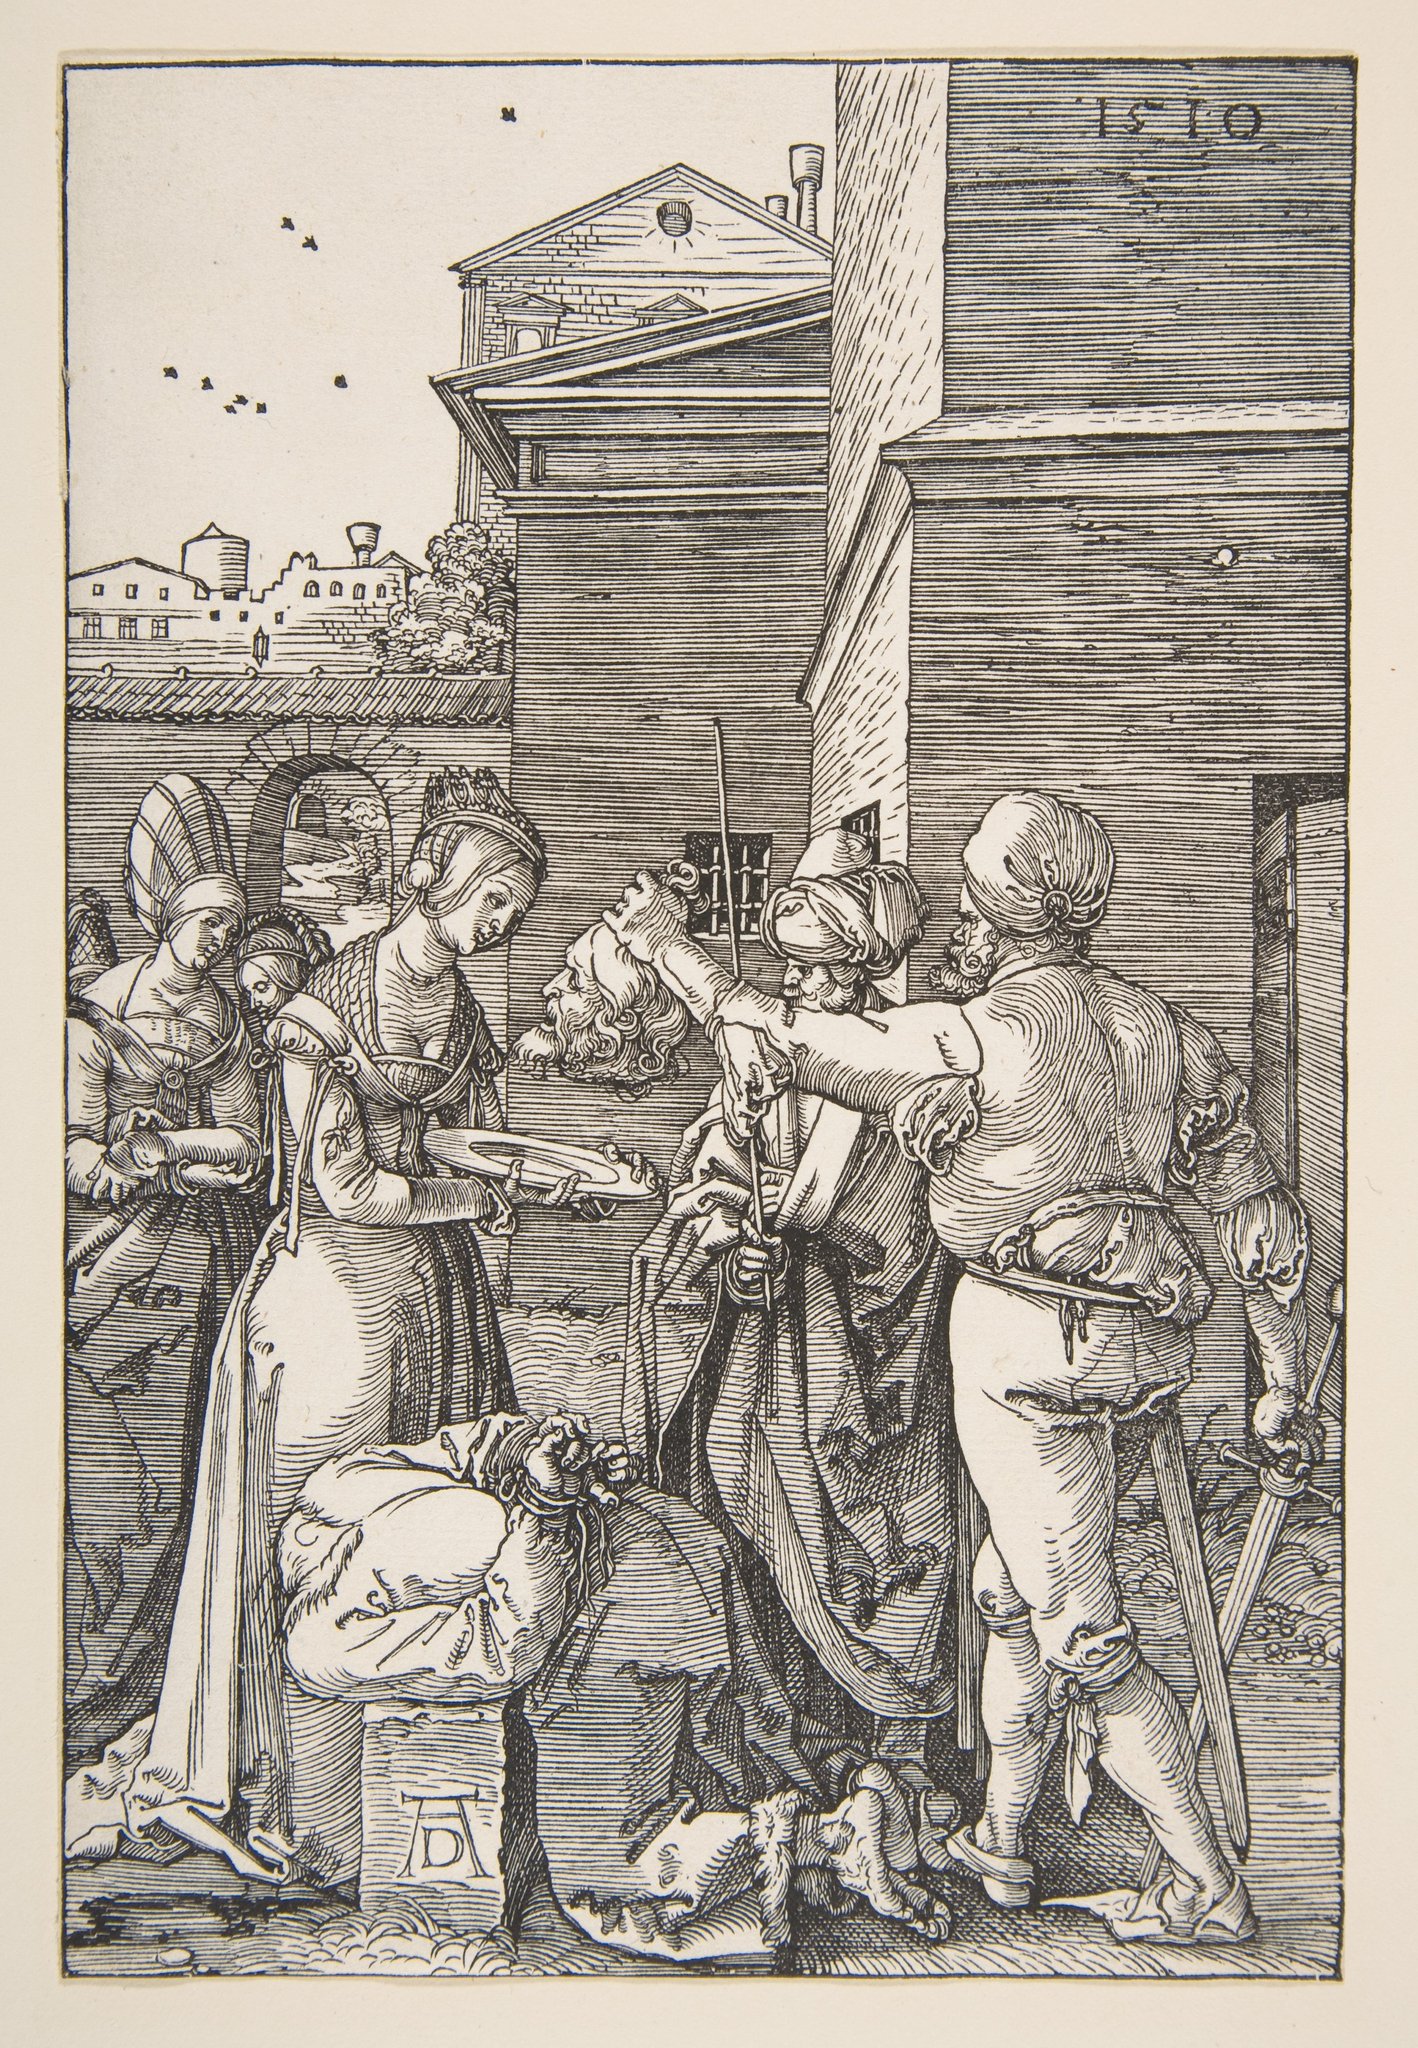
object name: print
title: The Beheading of Saint John the Baptist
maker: albrecht dürer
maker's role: artist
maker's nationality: german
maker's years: 1471-1528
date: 1510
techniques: woodcut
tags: heads,men,women,saint john the baptist